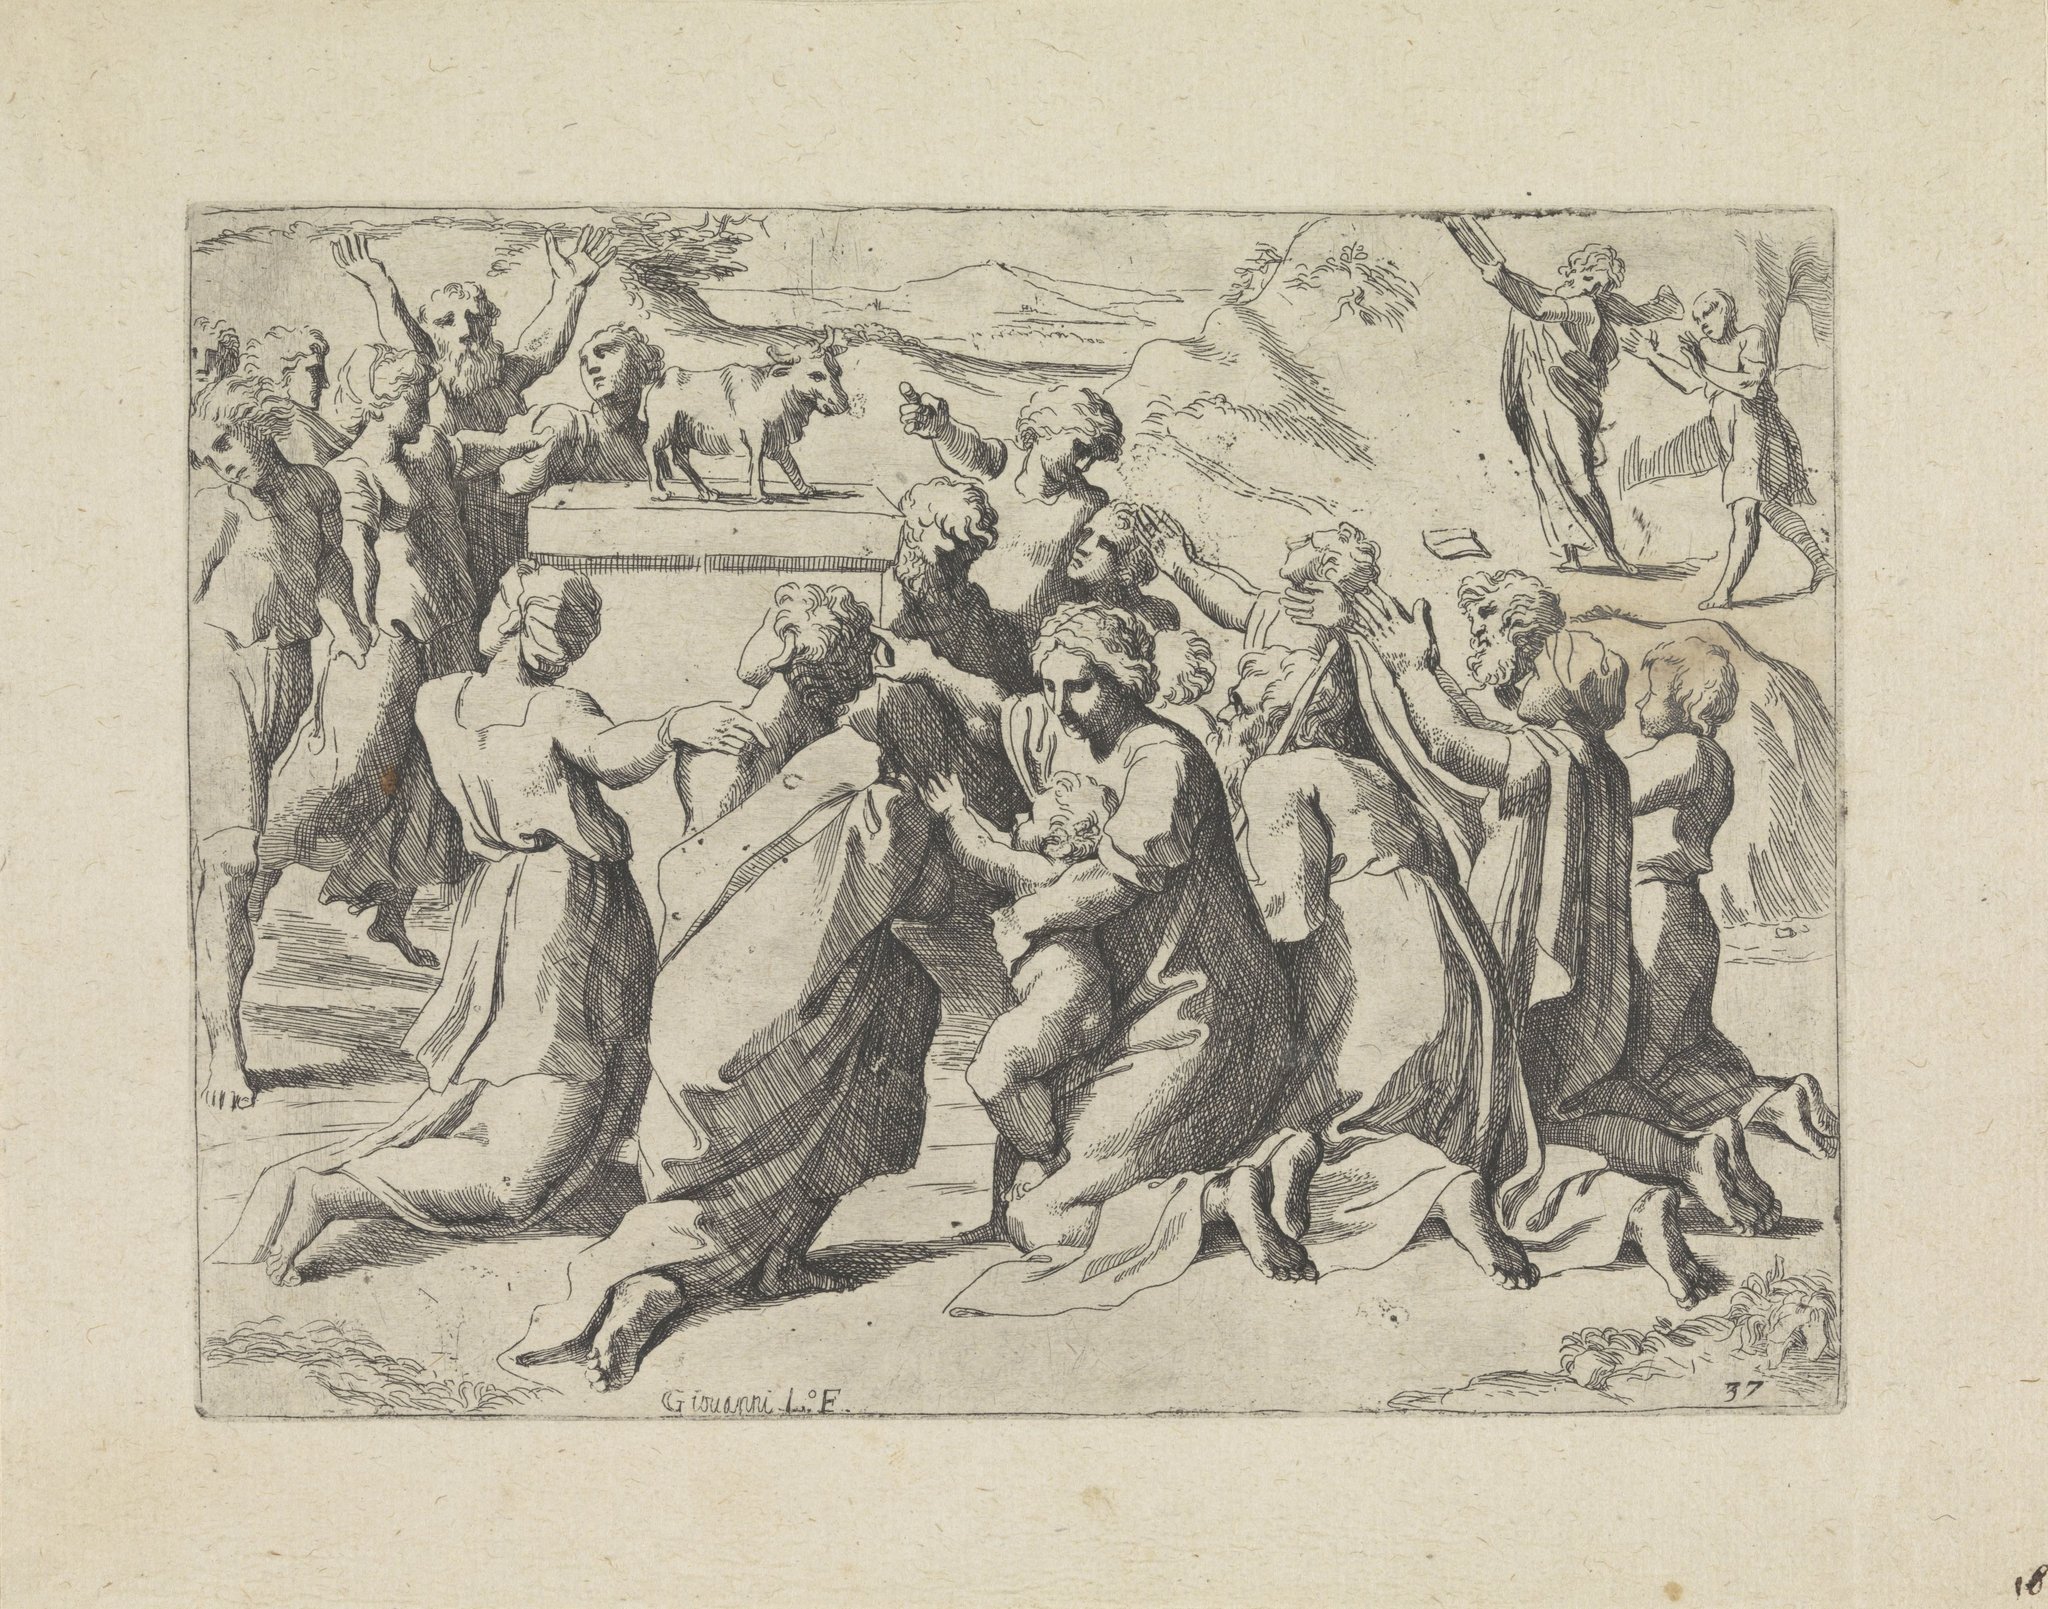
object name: print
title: Historia del Testamento Vecchio / Dipinta in Roma nel Vaticano da Raffaelle di Urbin (...)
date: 1607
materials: paper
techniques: etching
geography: italy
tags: the people dance around the golden calf ~ exodus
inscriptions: collector's mark: Lugt 11, number: ‘18’, collector's mark: ‘Hinloopen’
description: Op een blad geplakt met rechtsboven handgeschreven in pen in bruin: 138. Prent uit een reeks van 54 genummerde prenten naar schilderingen in de Loggia van Rafael in het Vaticaan.